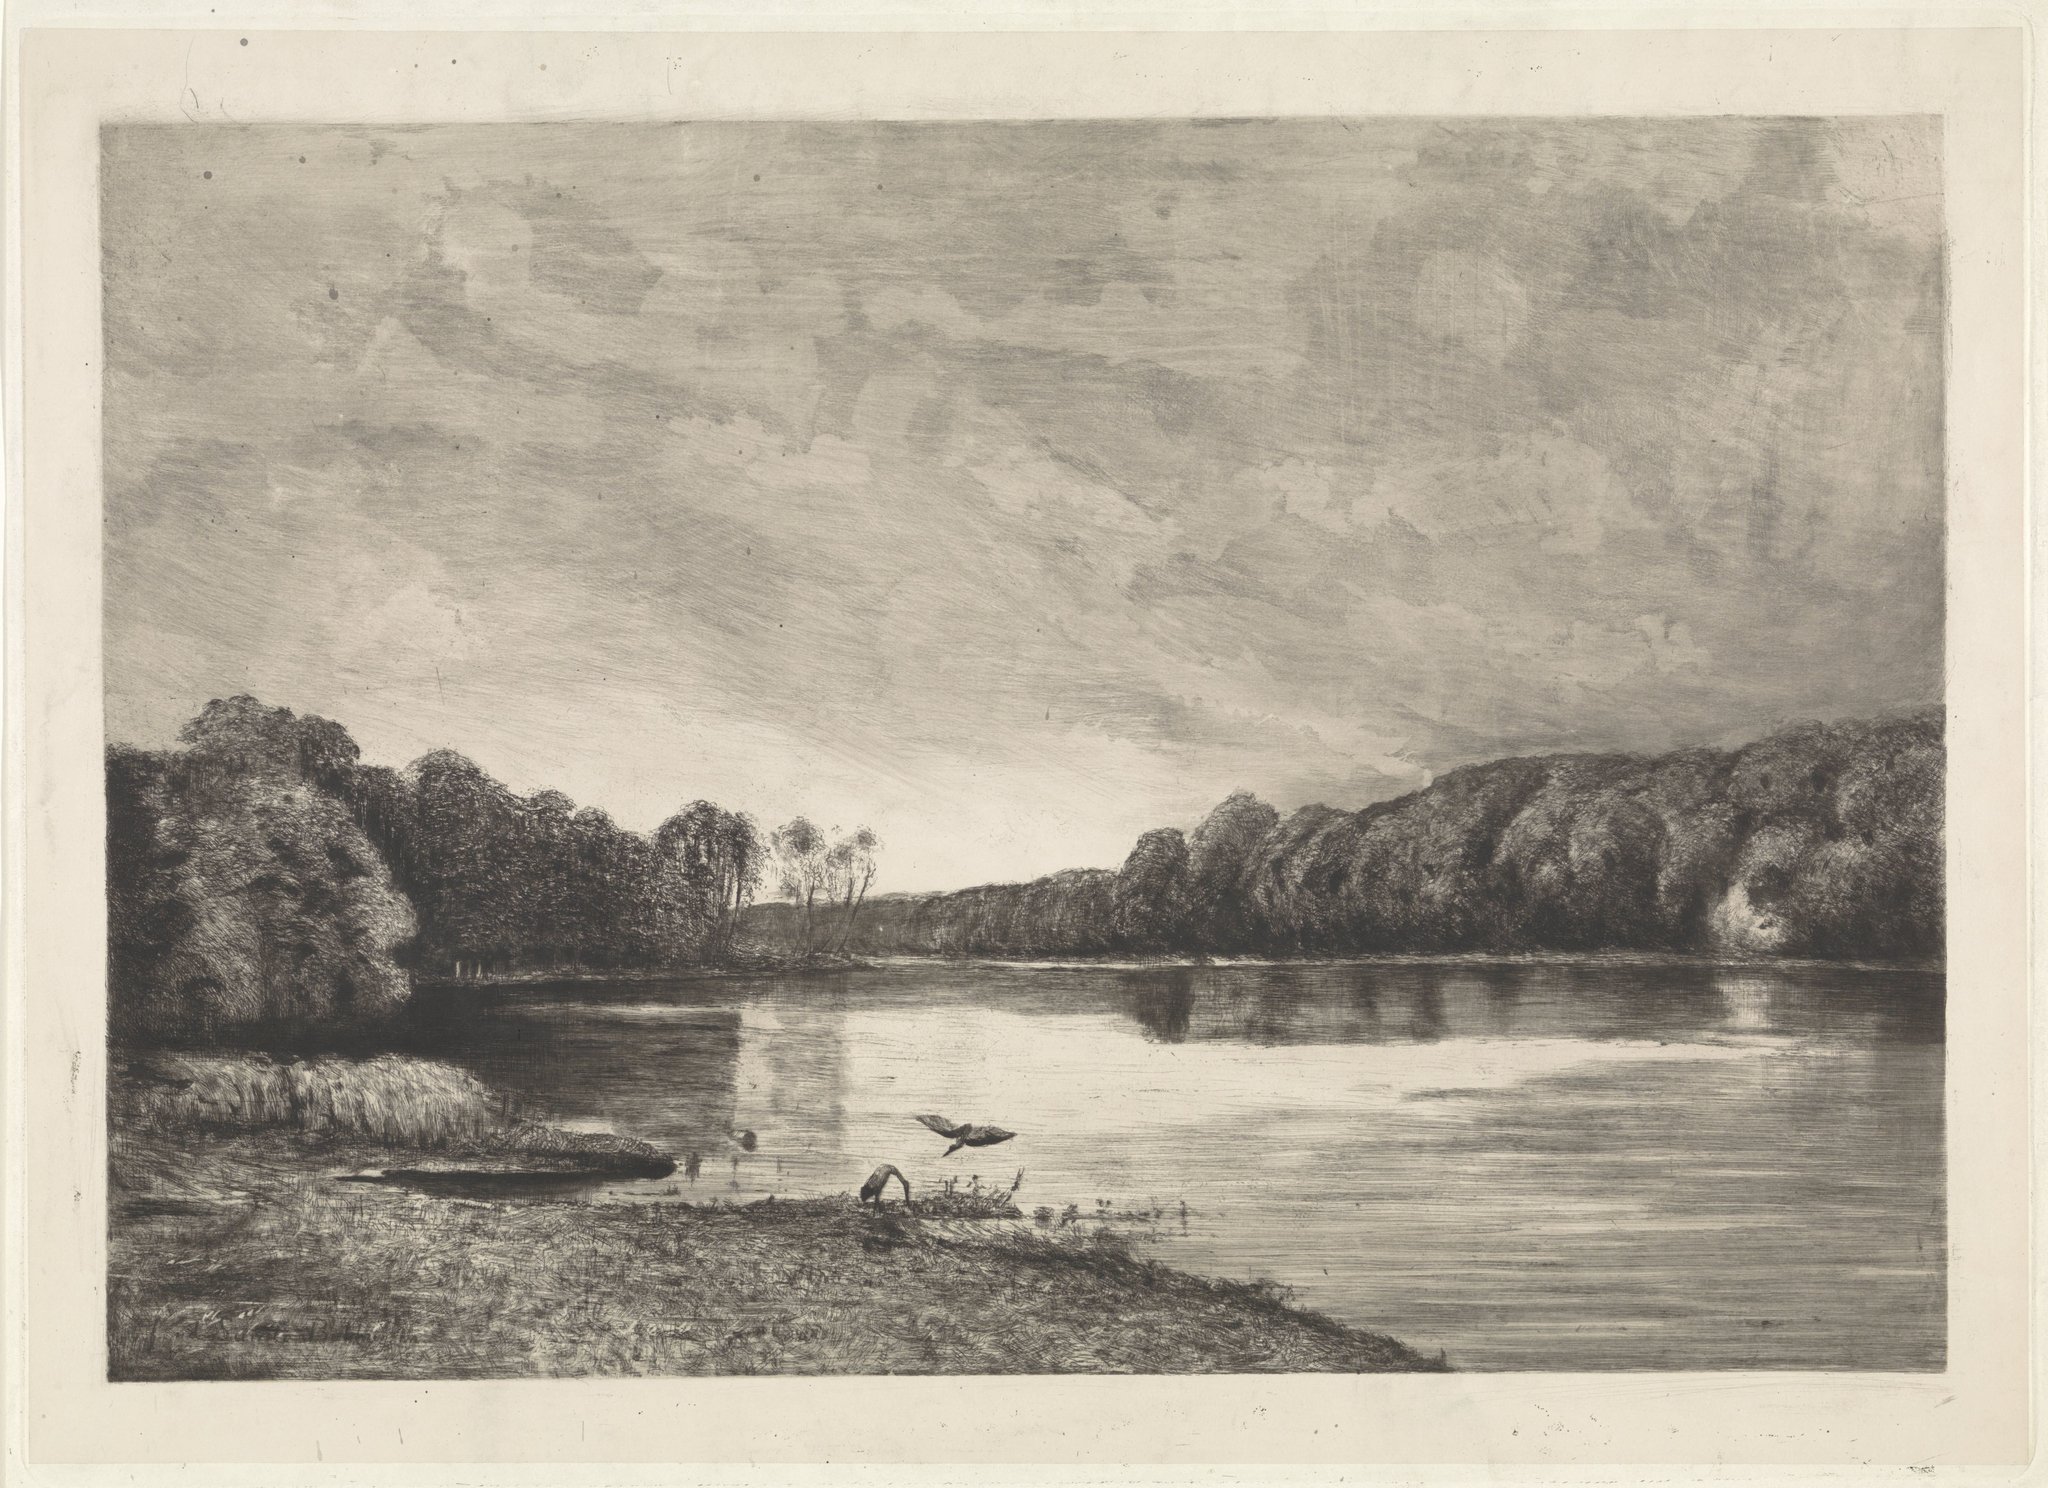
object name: print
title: Vijver met watervogels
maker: frans schikkinger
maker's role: print maker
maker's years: 1838-1902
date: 1848-1902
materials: paper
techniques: etching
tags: pond, pool, water-birds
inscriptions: collector's mark: Lugt 2228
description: Gezicht op een vijver, met op de voorgrond twee watervogels.